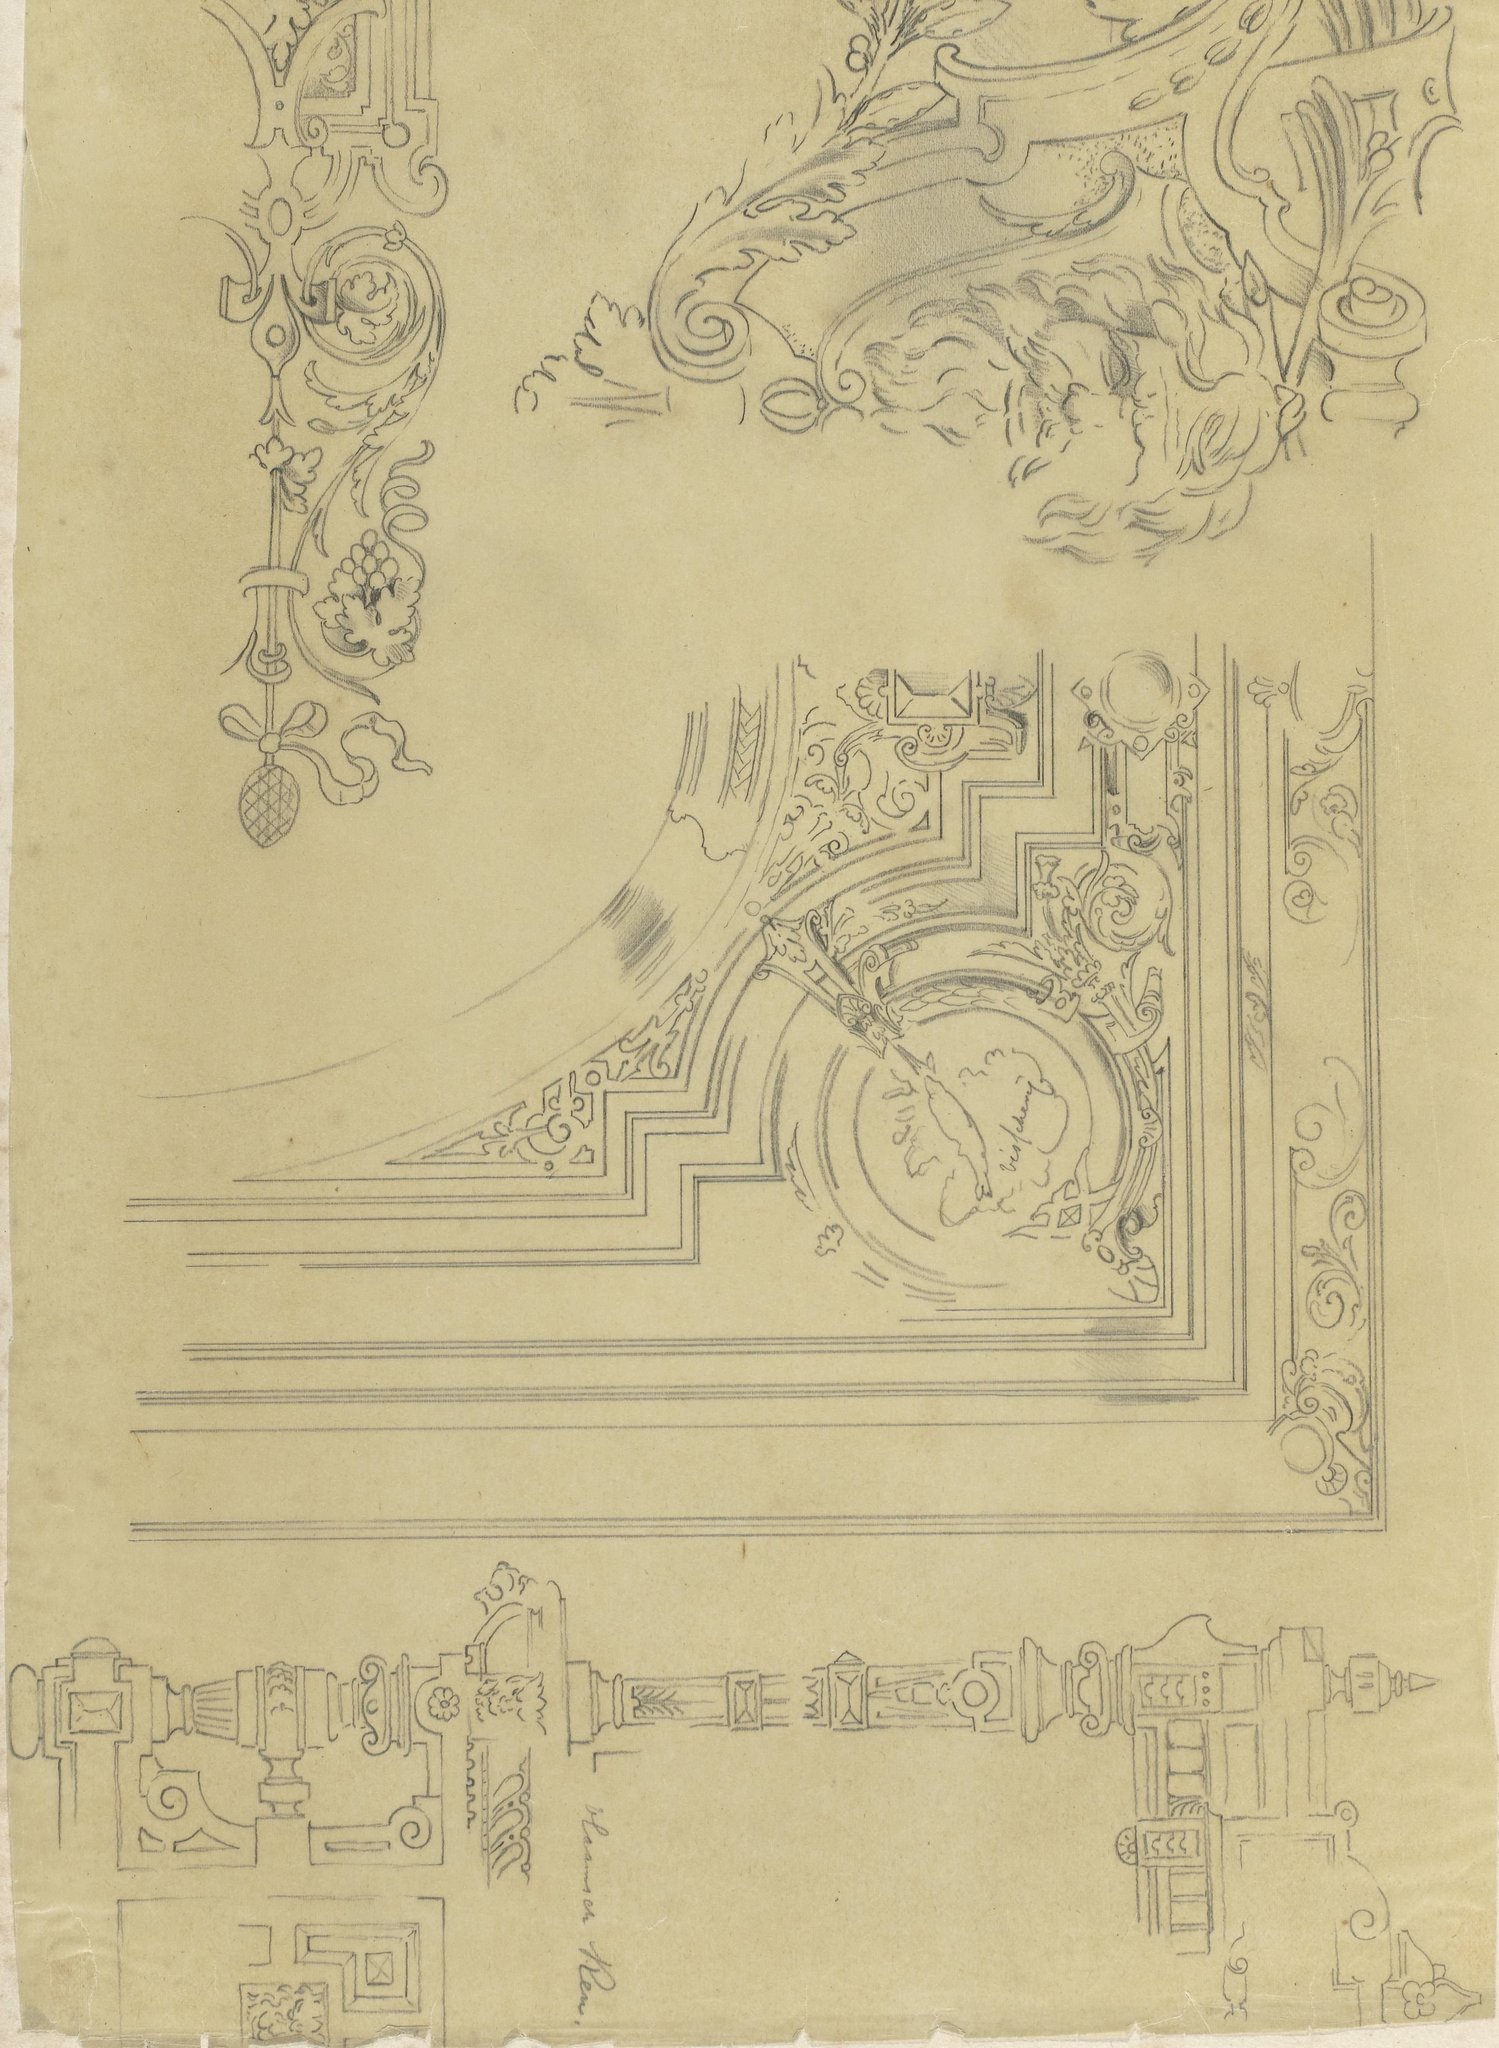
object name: drawing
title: Vier ornamenten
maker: Anonymous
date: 1866-1900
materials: pencil, paper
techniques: drawing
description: Helft van cartouche met masker, kwart van paneel, ornamentele rand en omlijsting waarbij staat: Vlaamsch Ren.